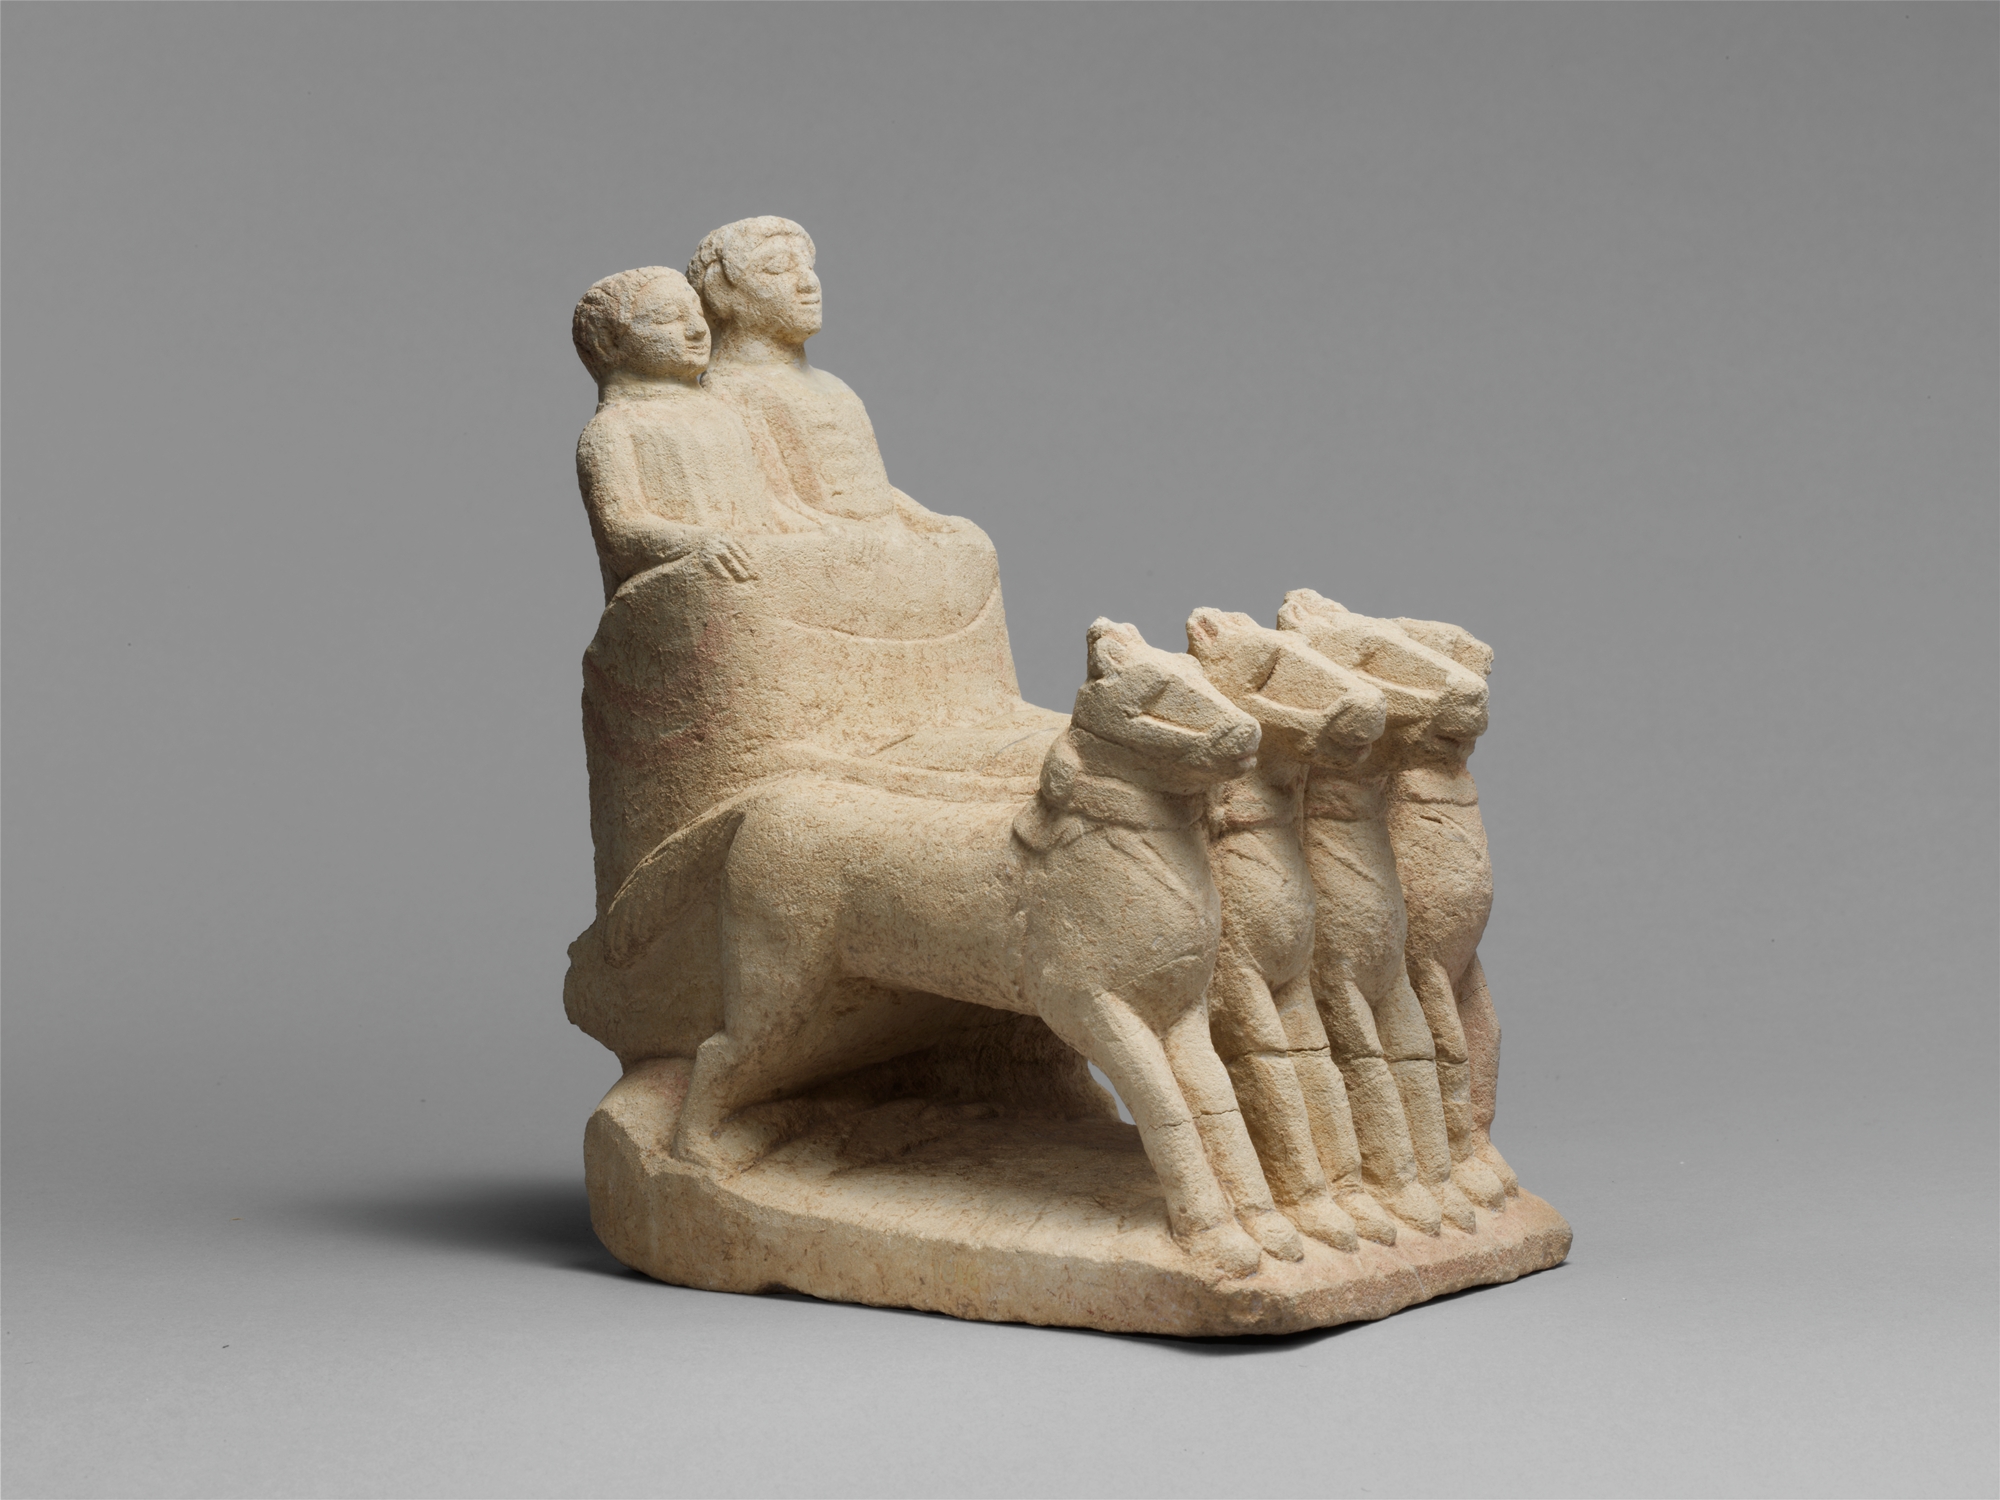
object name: chariot, votive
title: Limestone votive chariot with four horses and two figures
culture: cypriot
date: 700-501 BCE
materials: limestone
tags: men,horses,chariots